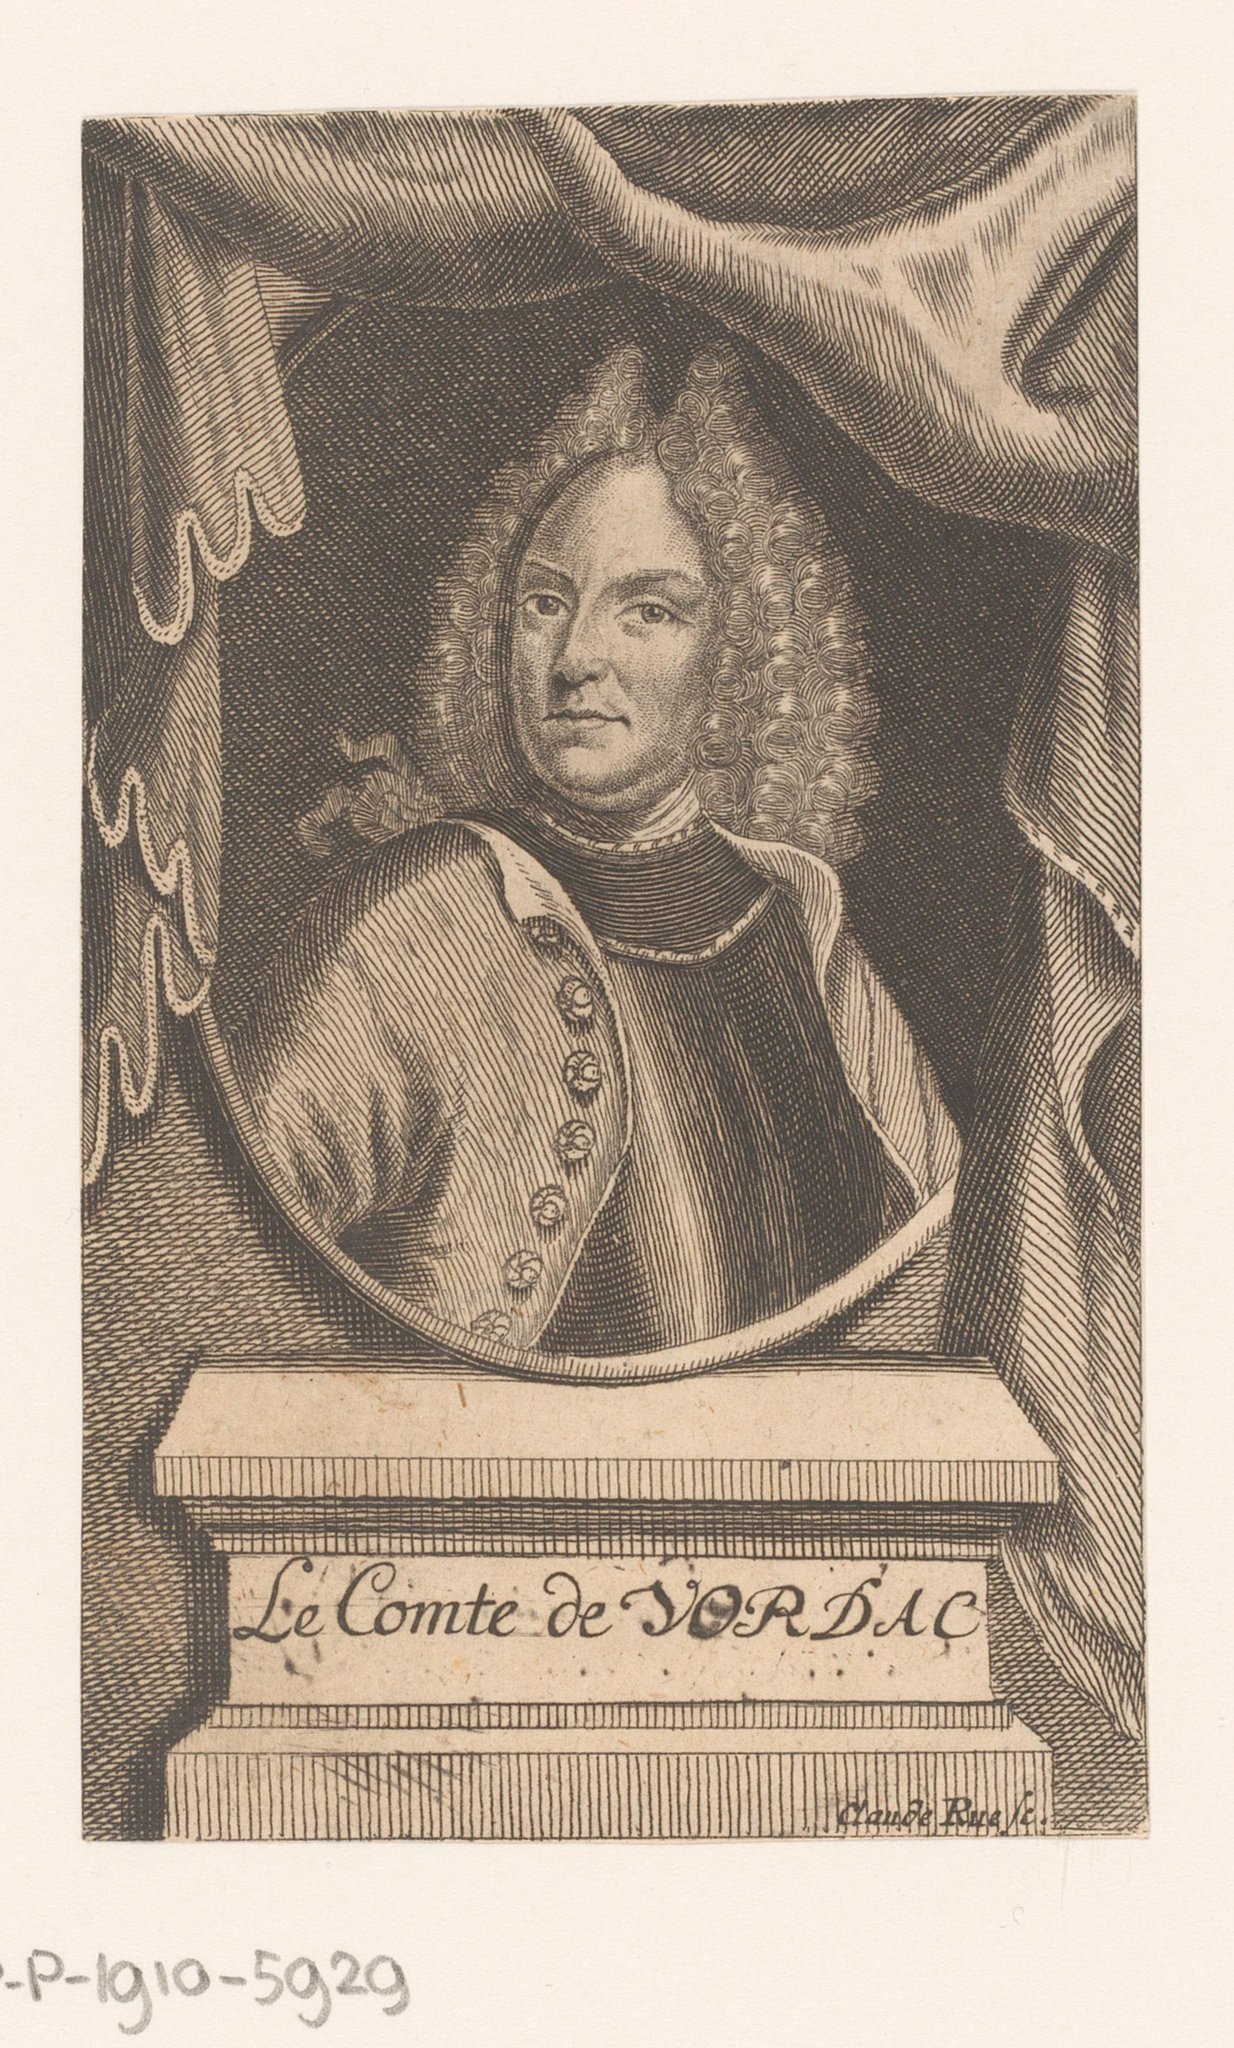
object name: book illustration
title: Portret van André Cavard, graaf van Vordac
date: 1702-1724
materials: paper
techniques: engraving, etching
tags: historical persons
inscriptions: collector's mark: Lugt 2228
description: Prent uit: Cavard, André. Les Mémoires du Comte de Vordac, general des armées de l’empereur. Parijs: Guillaume Cavalier, 1724.